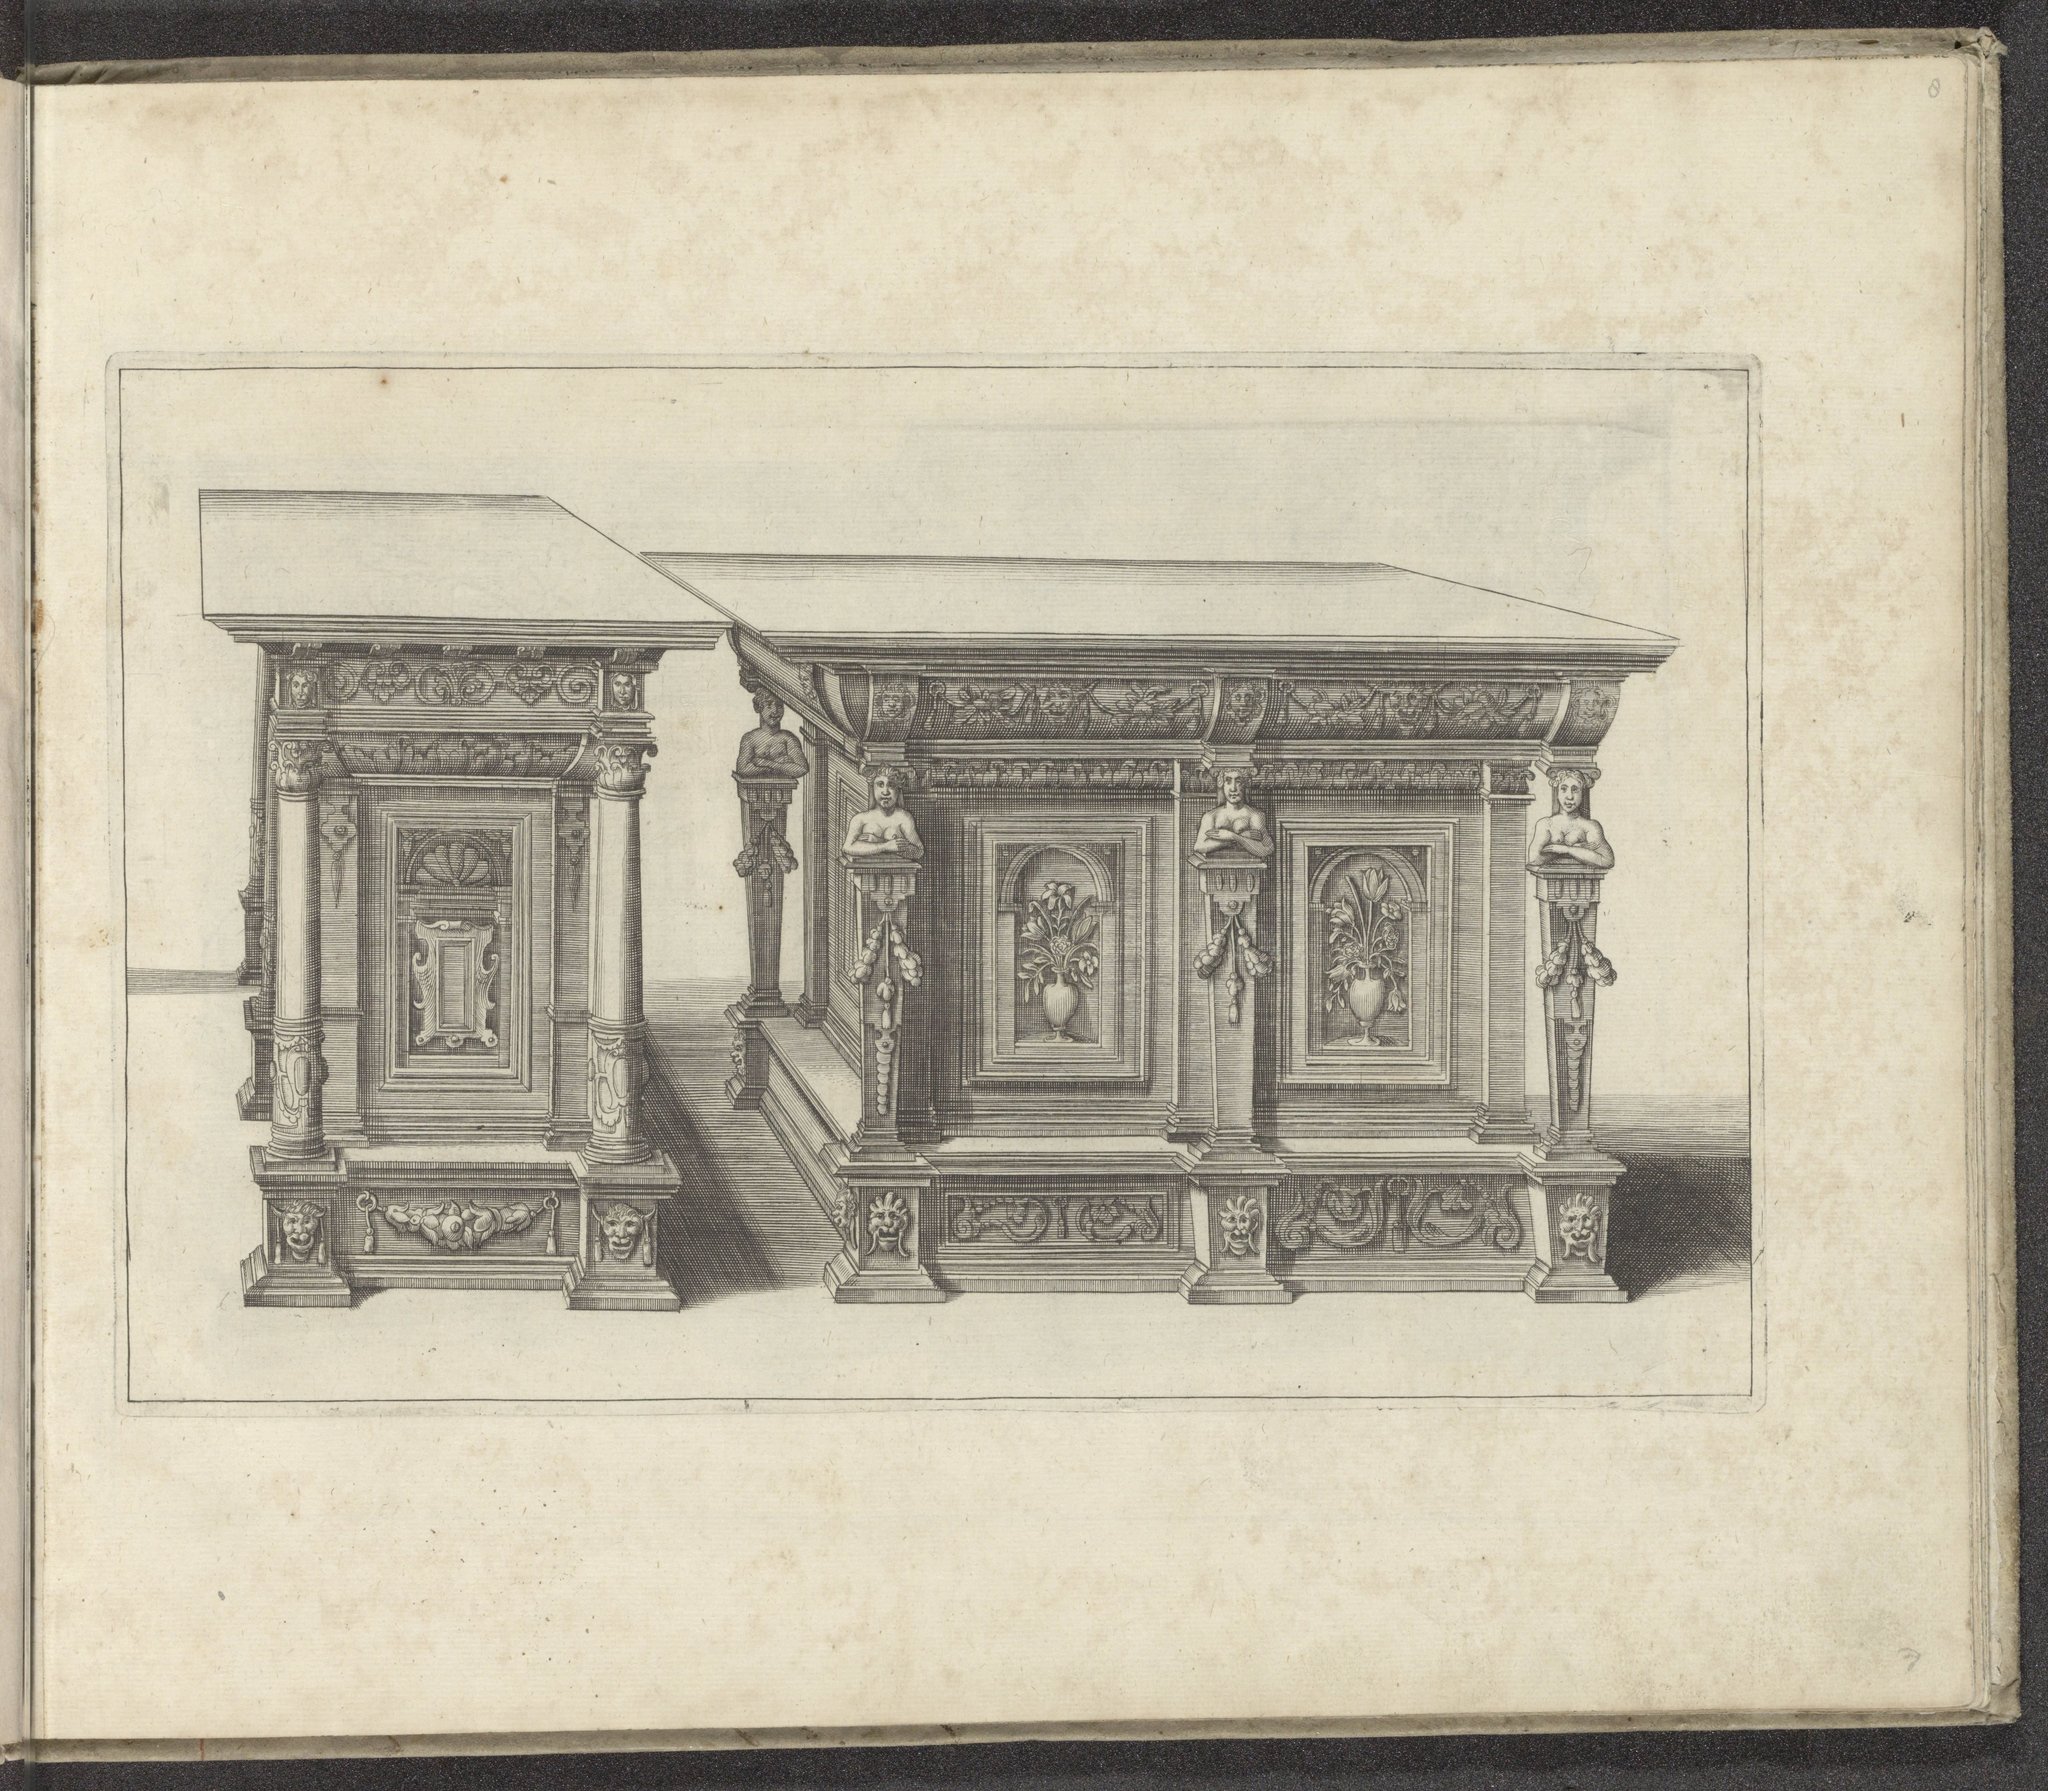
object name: ornament print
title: Twee kasten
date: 1658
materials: paper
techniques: engraving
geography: cologne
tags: furniture for storage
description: Twee kasten. Van de linker kast wordt de zijkant weergegeven. De rechter kast heeft termen als zuilen en deuren gedecoreerd met een bloemenvaas. De prent maakt deel uit van een album.